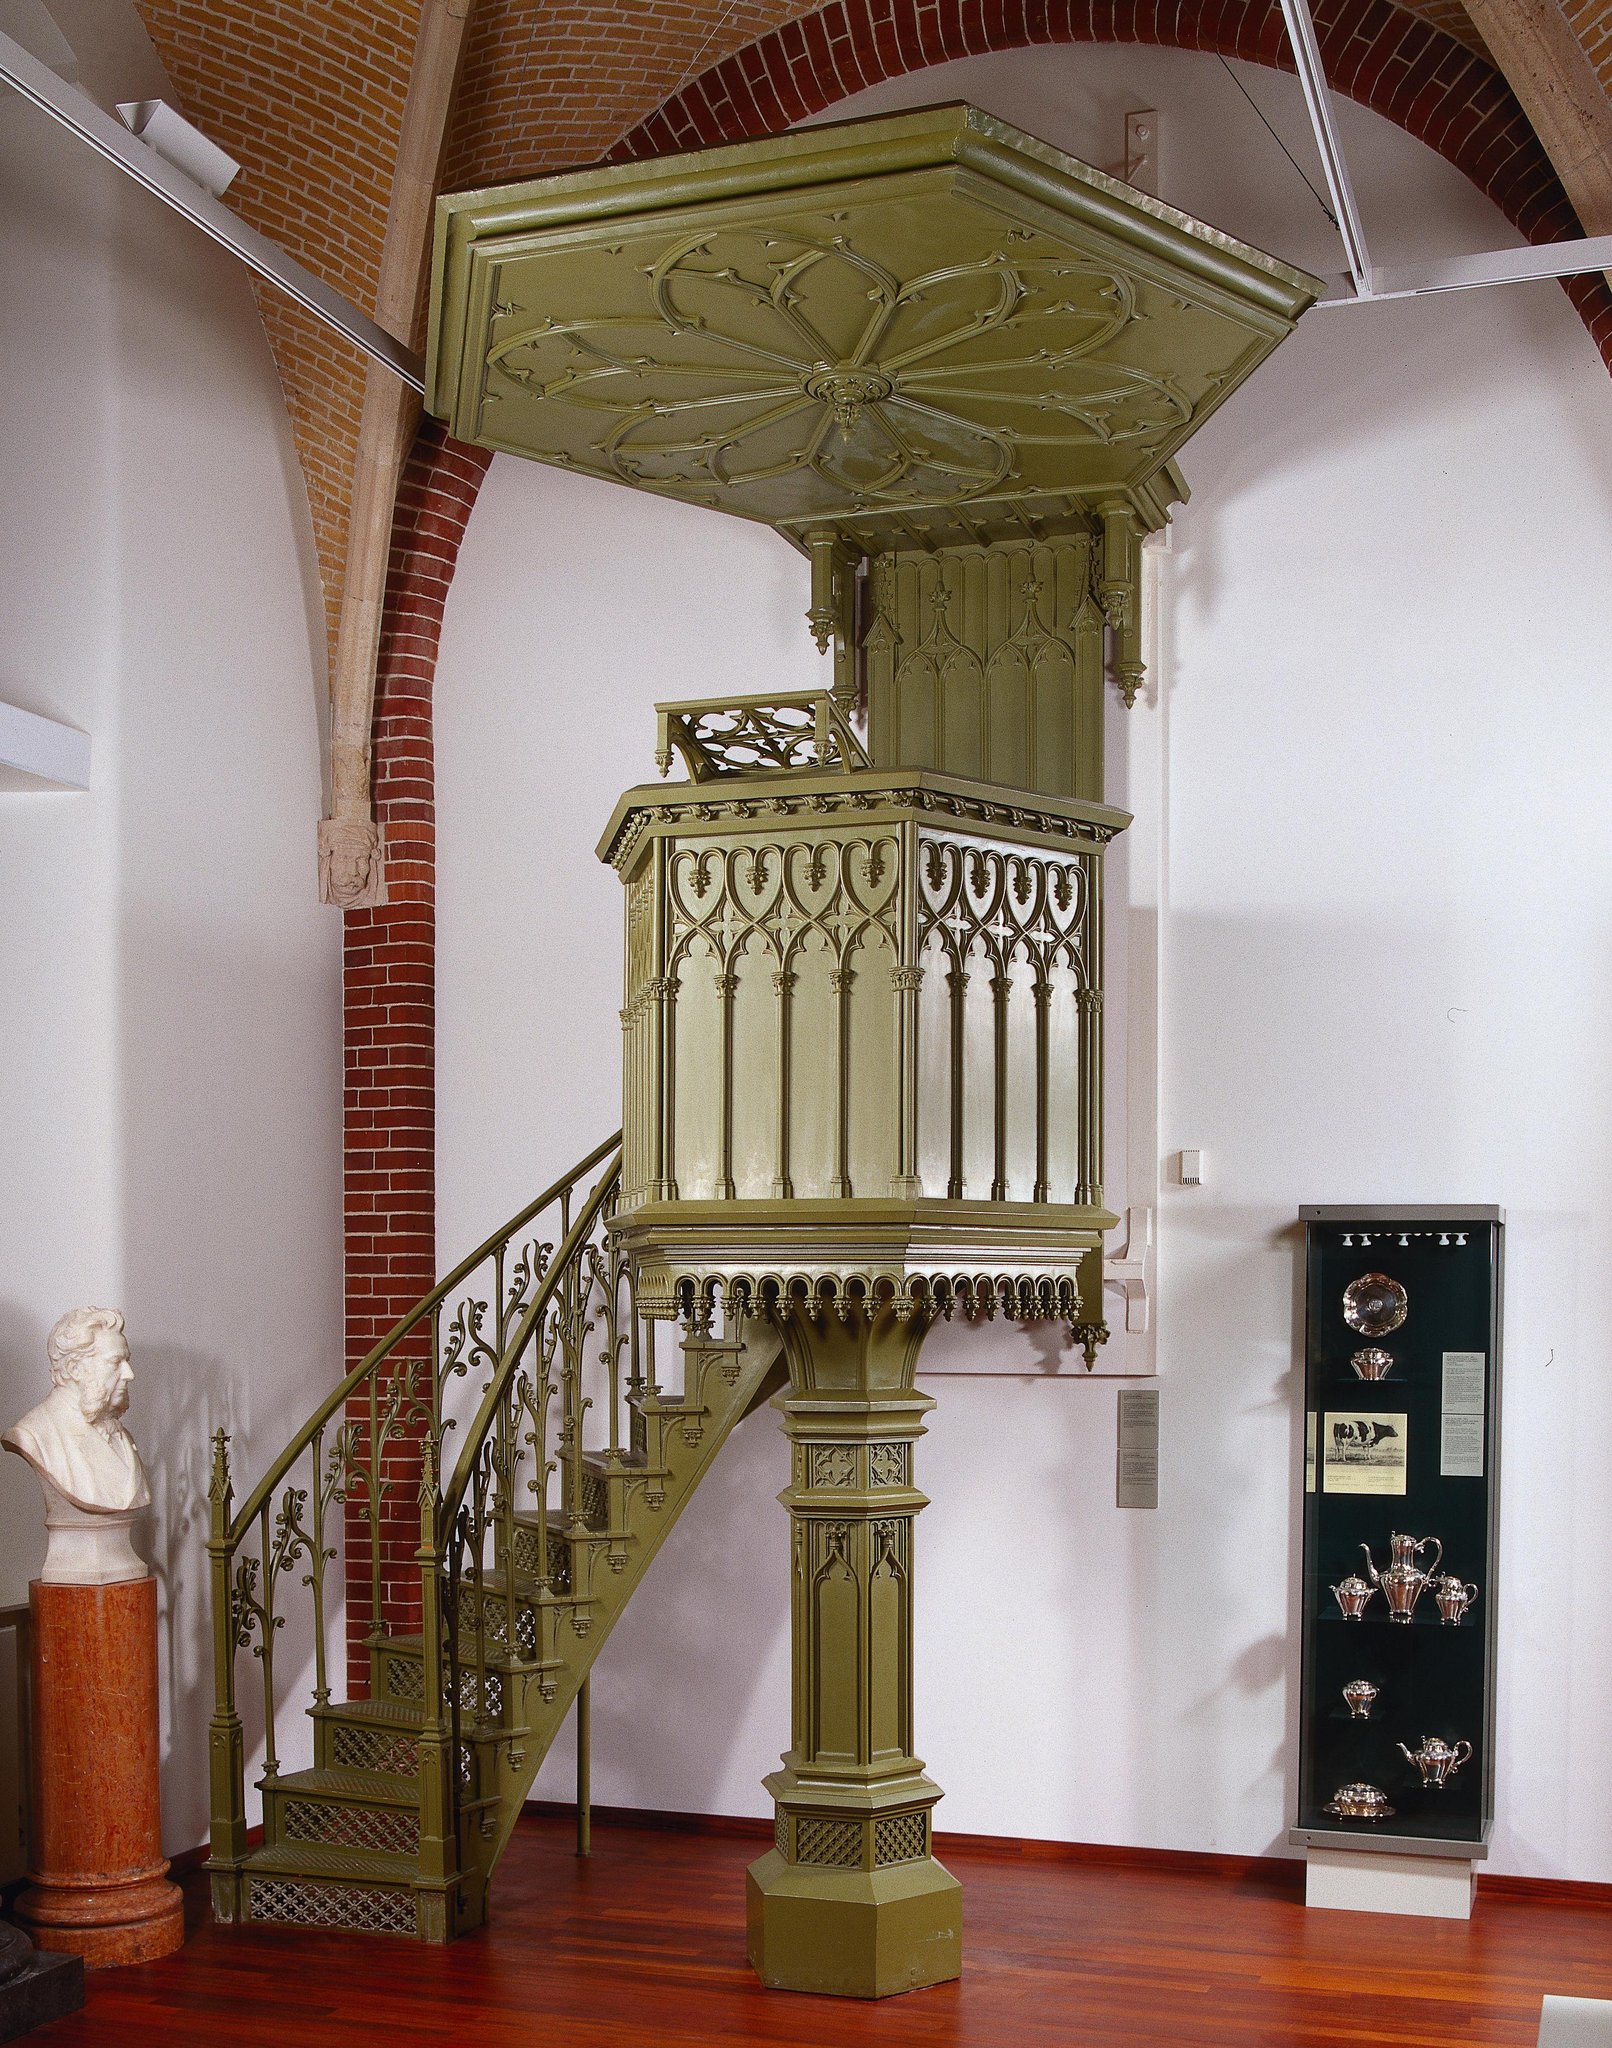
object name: console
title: Gietijzeren preekstoel uit de Nederlands Hervormde Kerk te Voorschoten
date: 1867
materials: iron, paint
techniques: casting, fastening, painted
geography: the hague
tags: ornament ~ tracery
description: Groen geverfde gietijzeren achterwand van een console bestaande uit acht onderdelen.